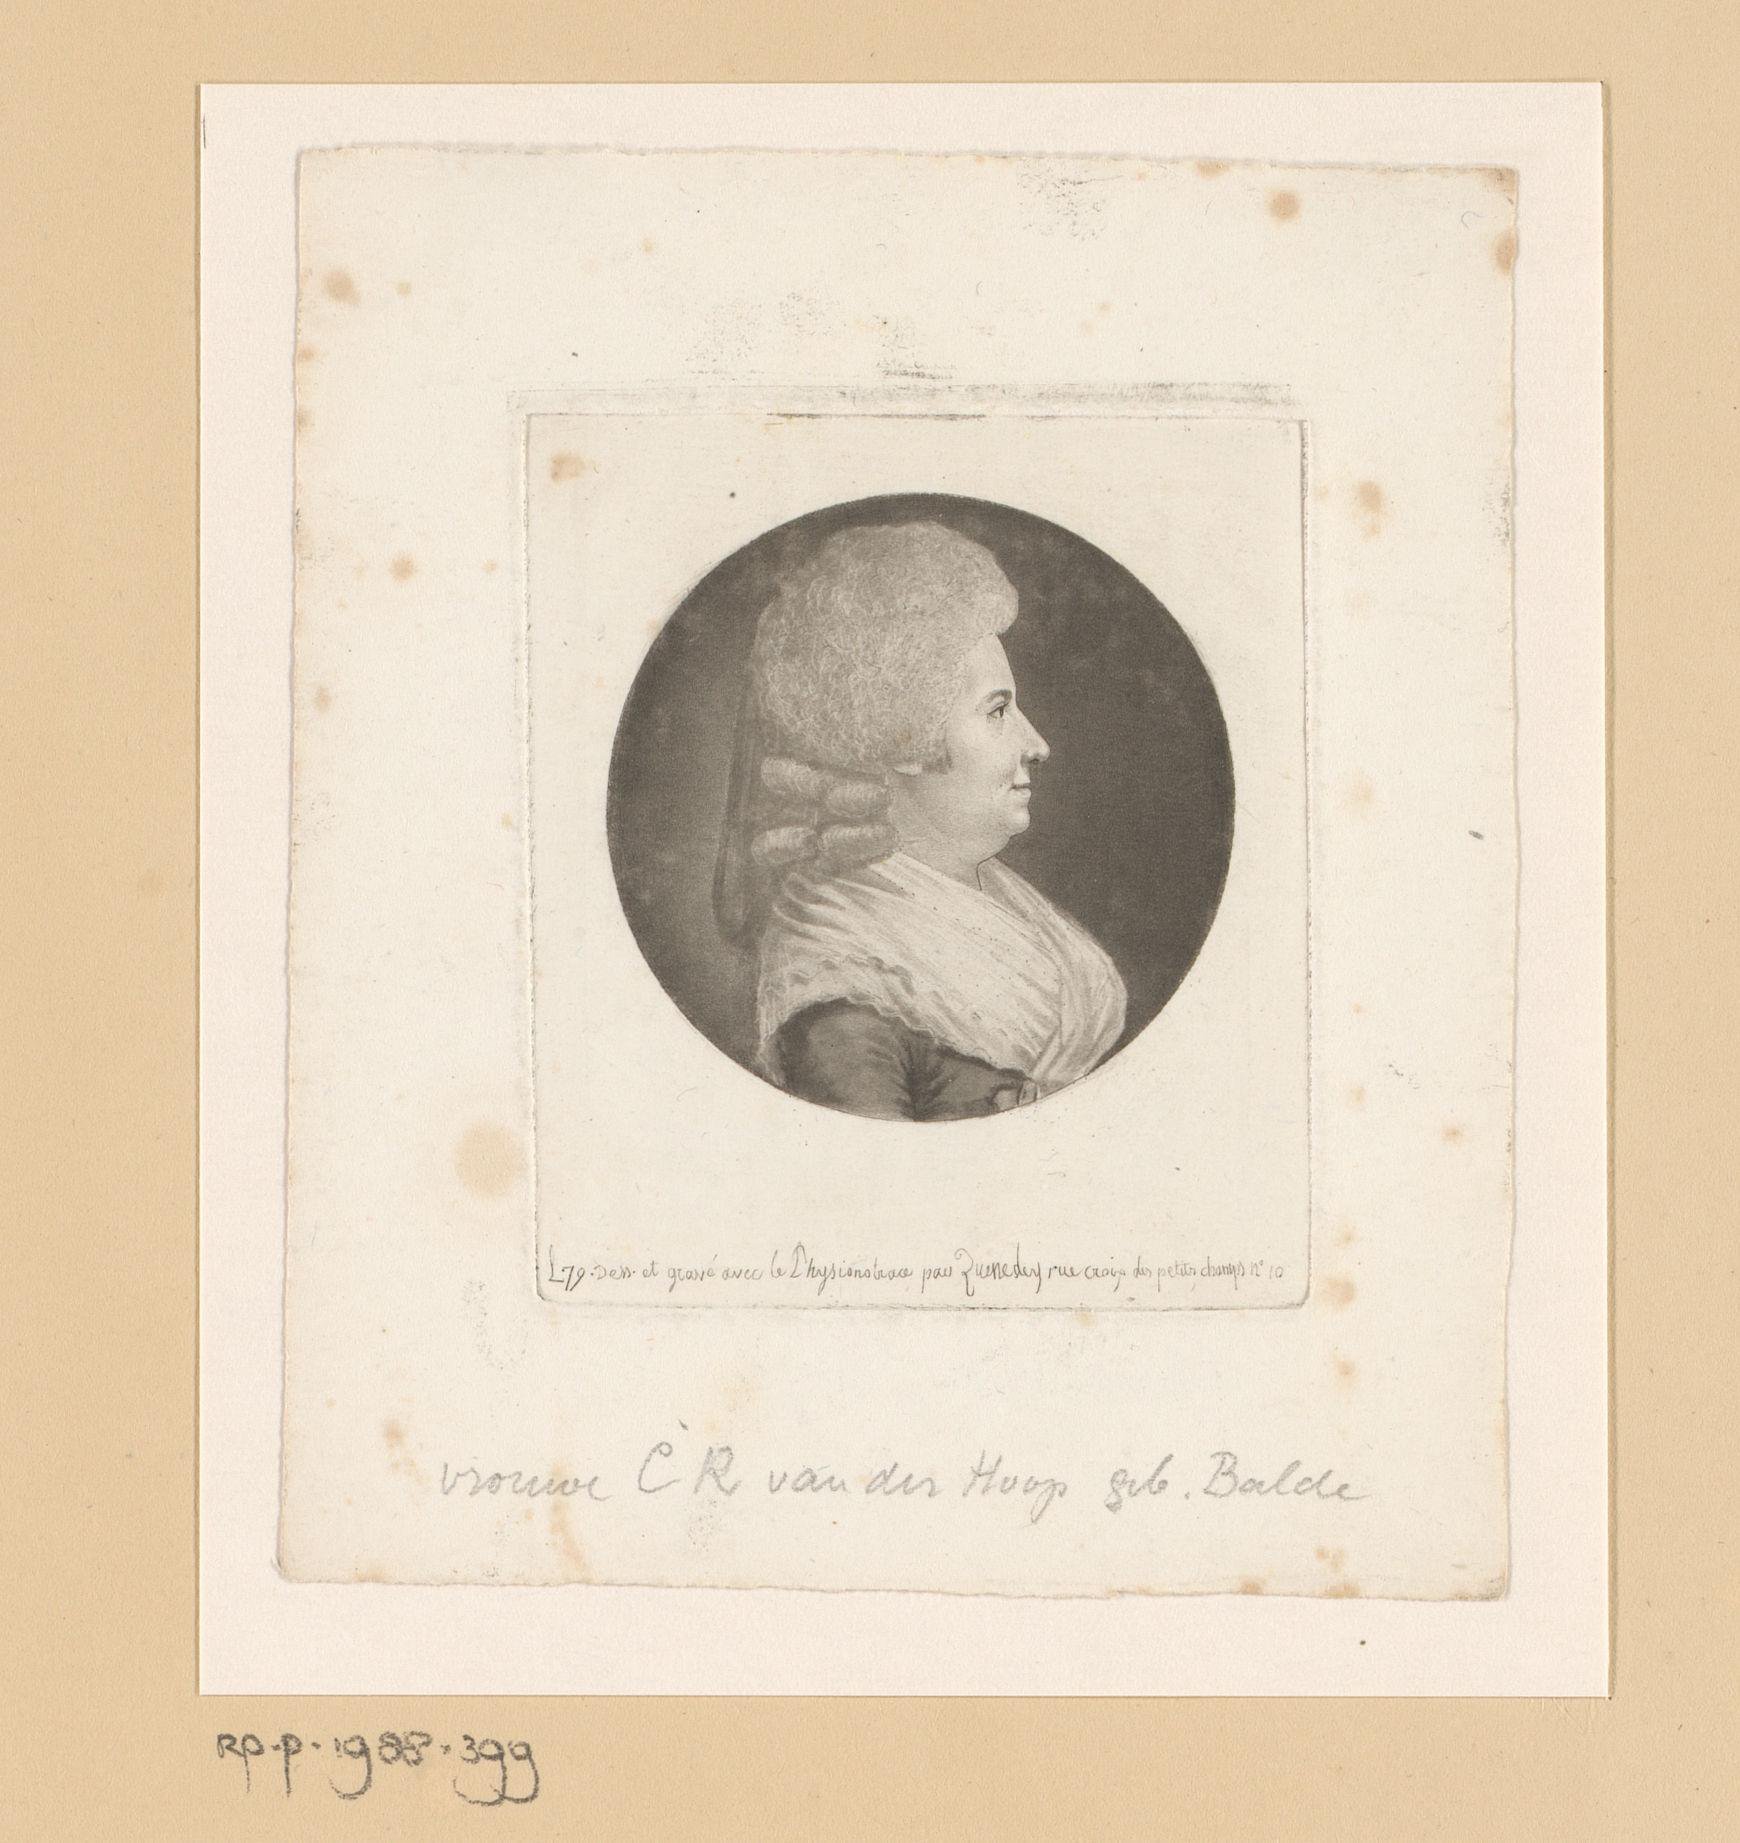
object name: physionotrace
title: Portret van Regina Catharina van der Hoop-Balde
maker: edme quenedey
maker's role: print maker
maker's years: 1756-1830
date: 1758-1830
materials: paper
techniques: aquatint, etching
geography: paris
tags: silhouette-apparatus, 'physionotrace', historical persons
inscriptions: collector's mark: Lugt 2228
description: Deze prent heeft het nummer L.79 in het fonds van Quenedey.